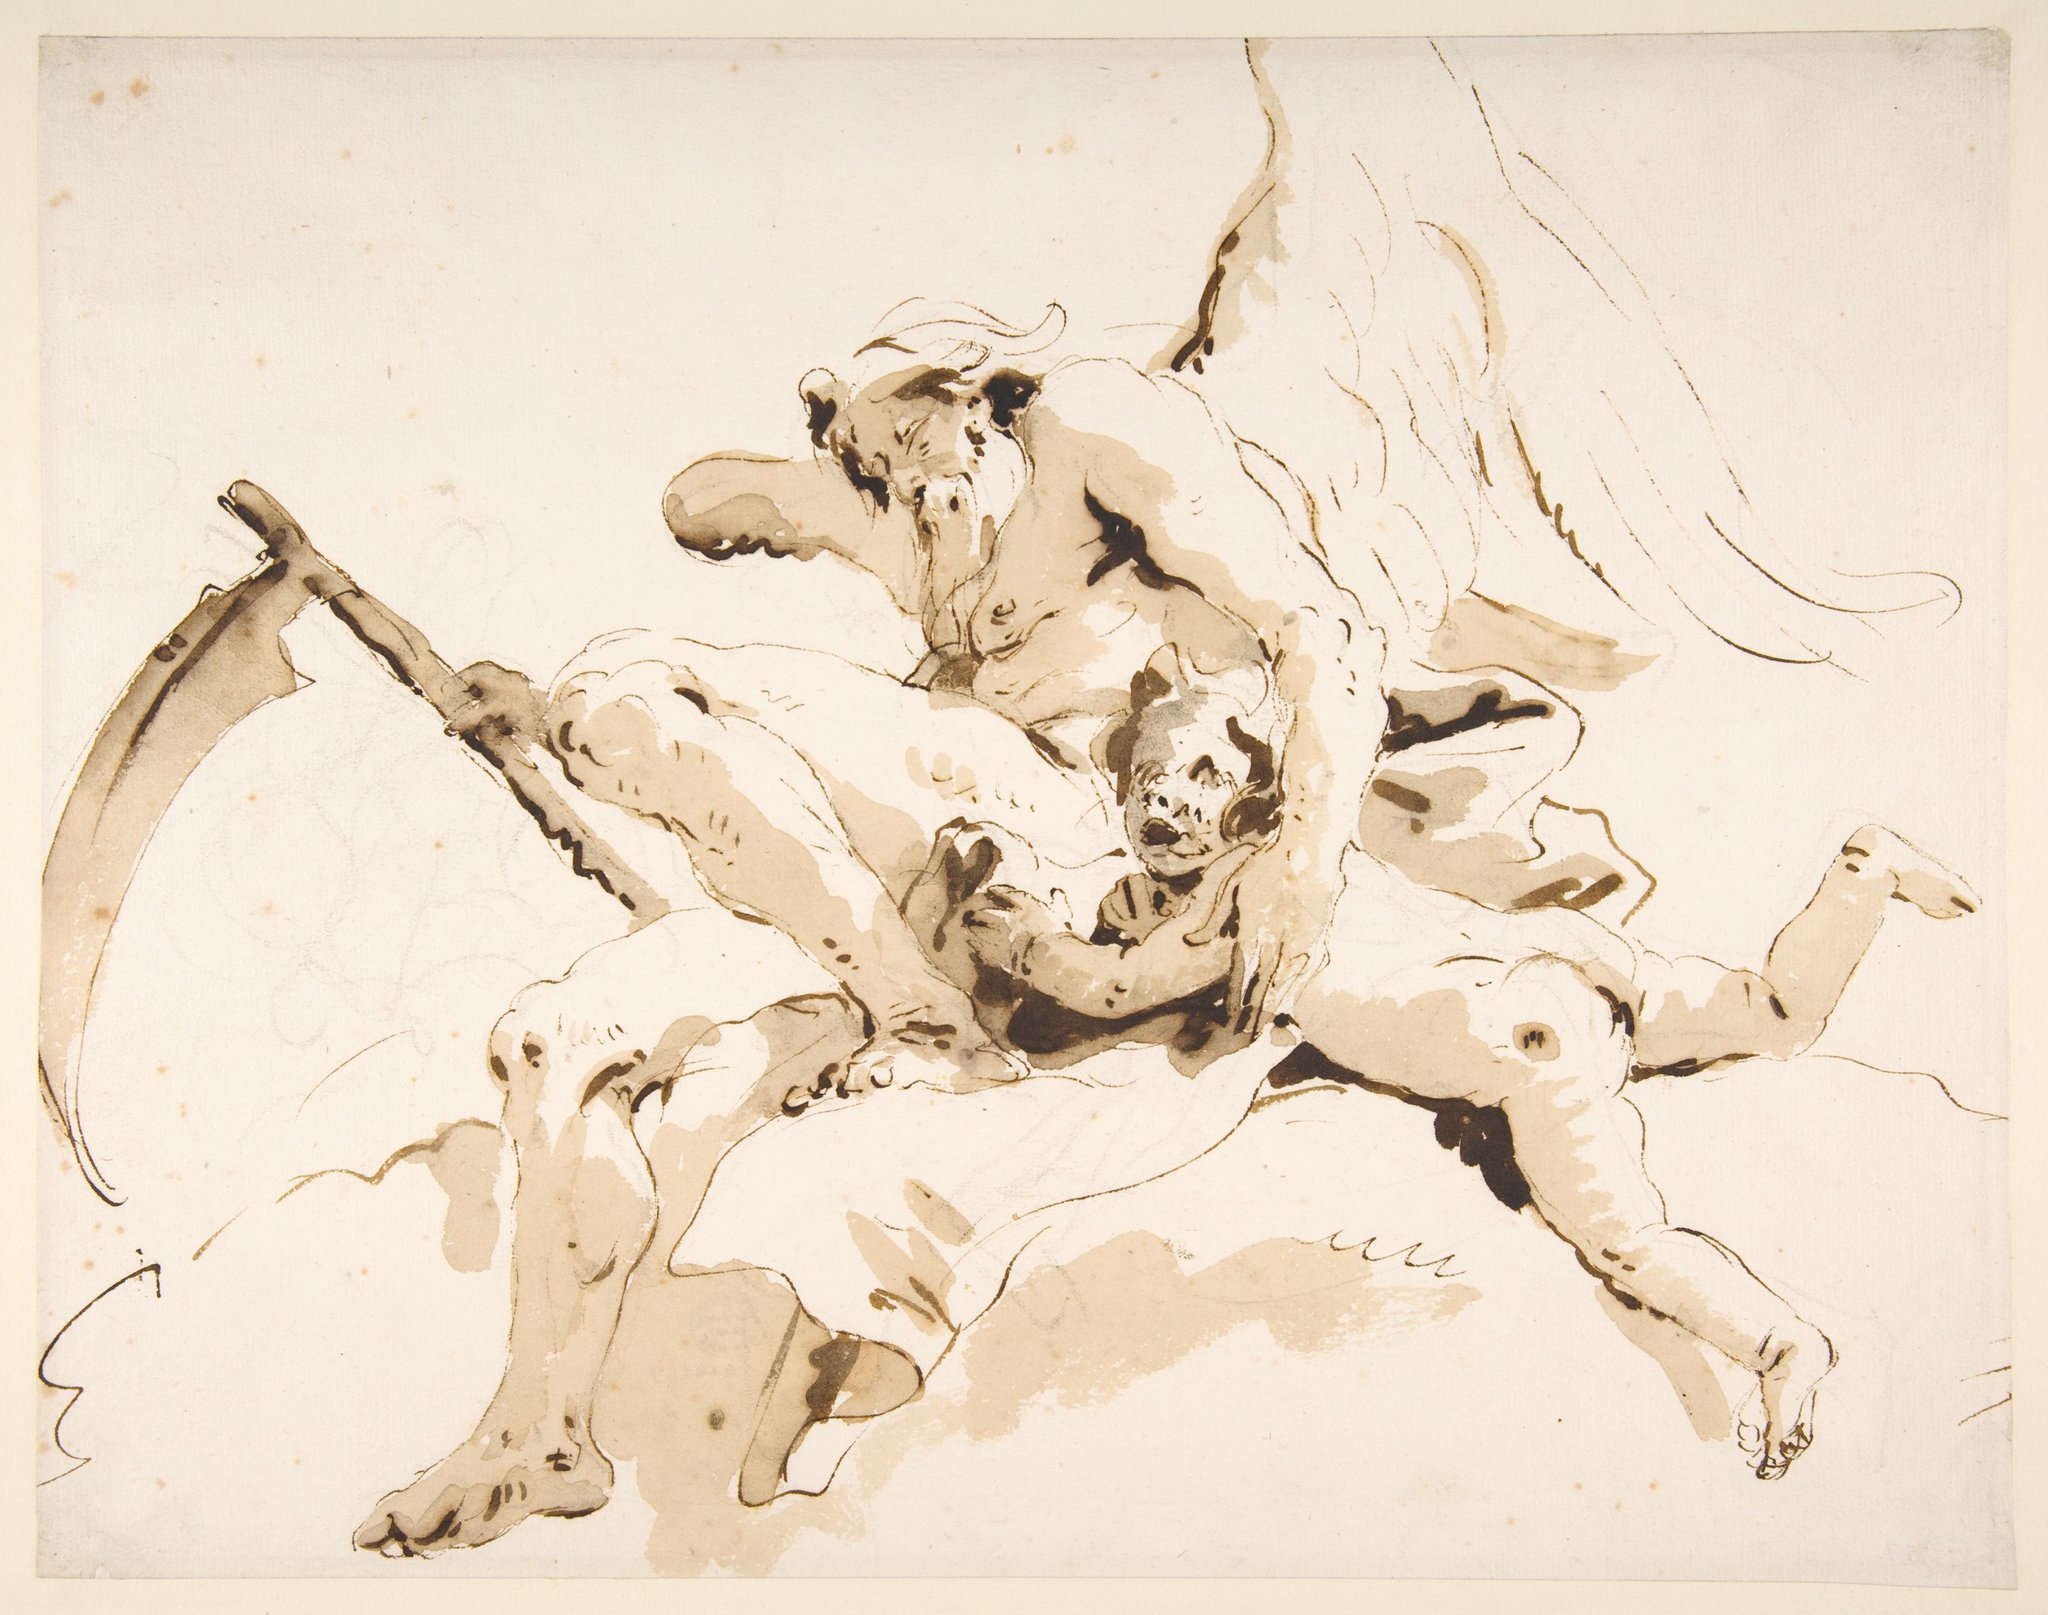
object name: drawing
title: Time Seated, Clutching a Putto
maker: giovanni battista tiepolo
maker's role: artist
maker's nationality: italian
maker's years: 1696-1770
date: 1696-1770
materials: chalk, ink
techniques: brush, pen, wash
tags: weapons,men